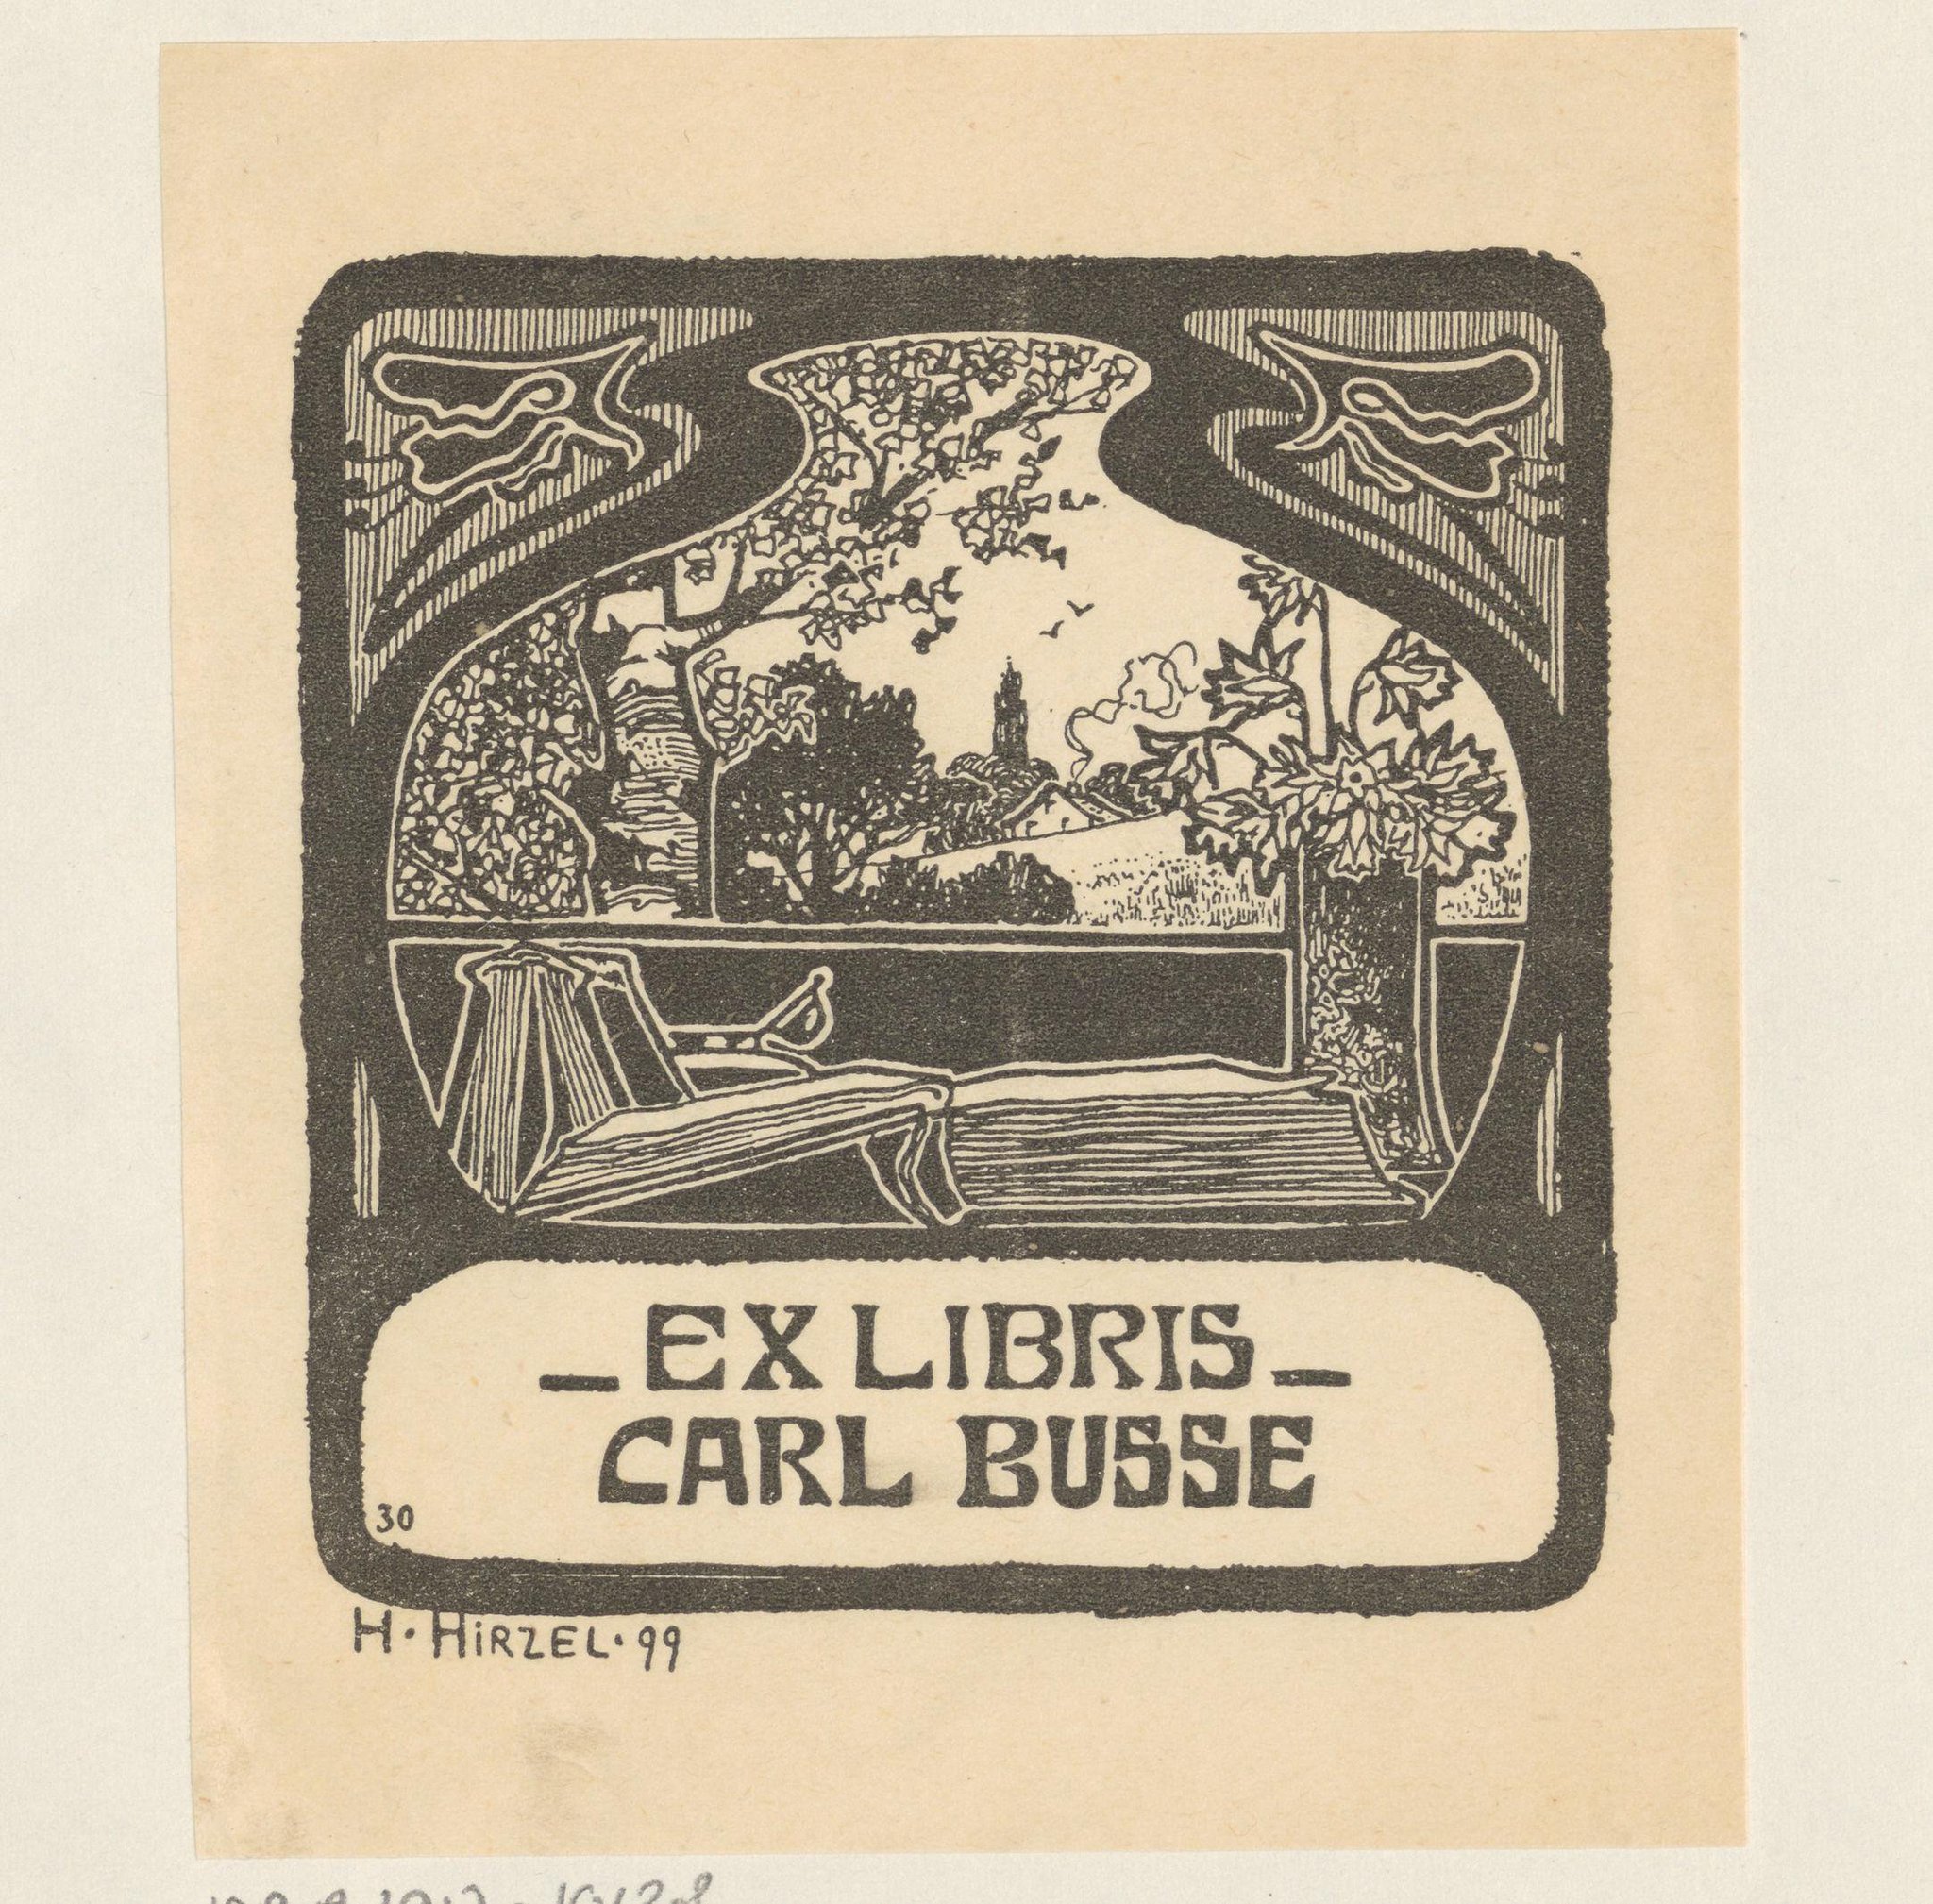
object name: bookplate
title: Ex libris van Carl Busse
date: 1899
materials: paper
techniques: printing block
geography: germany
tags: flowers, landscapes, book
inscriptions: date